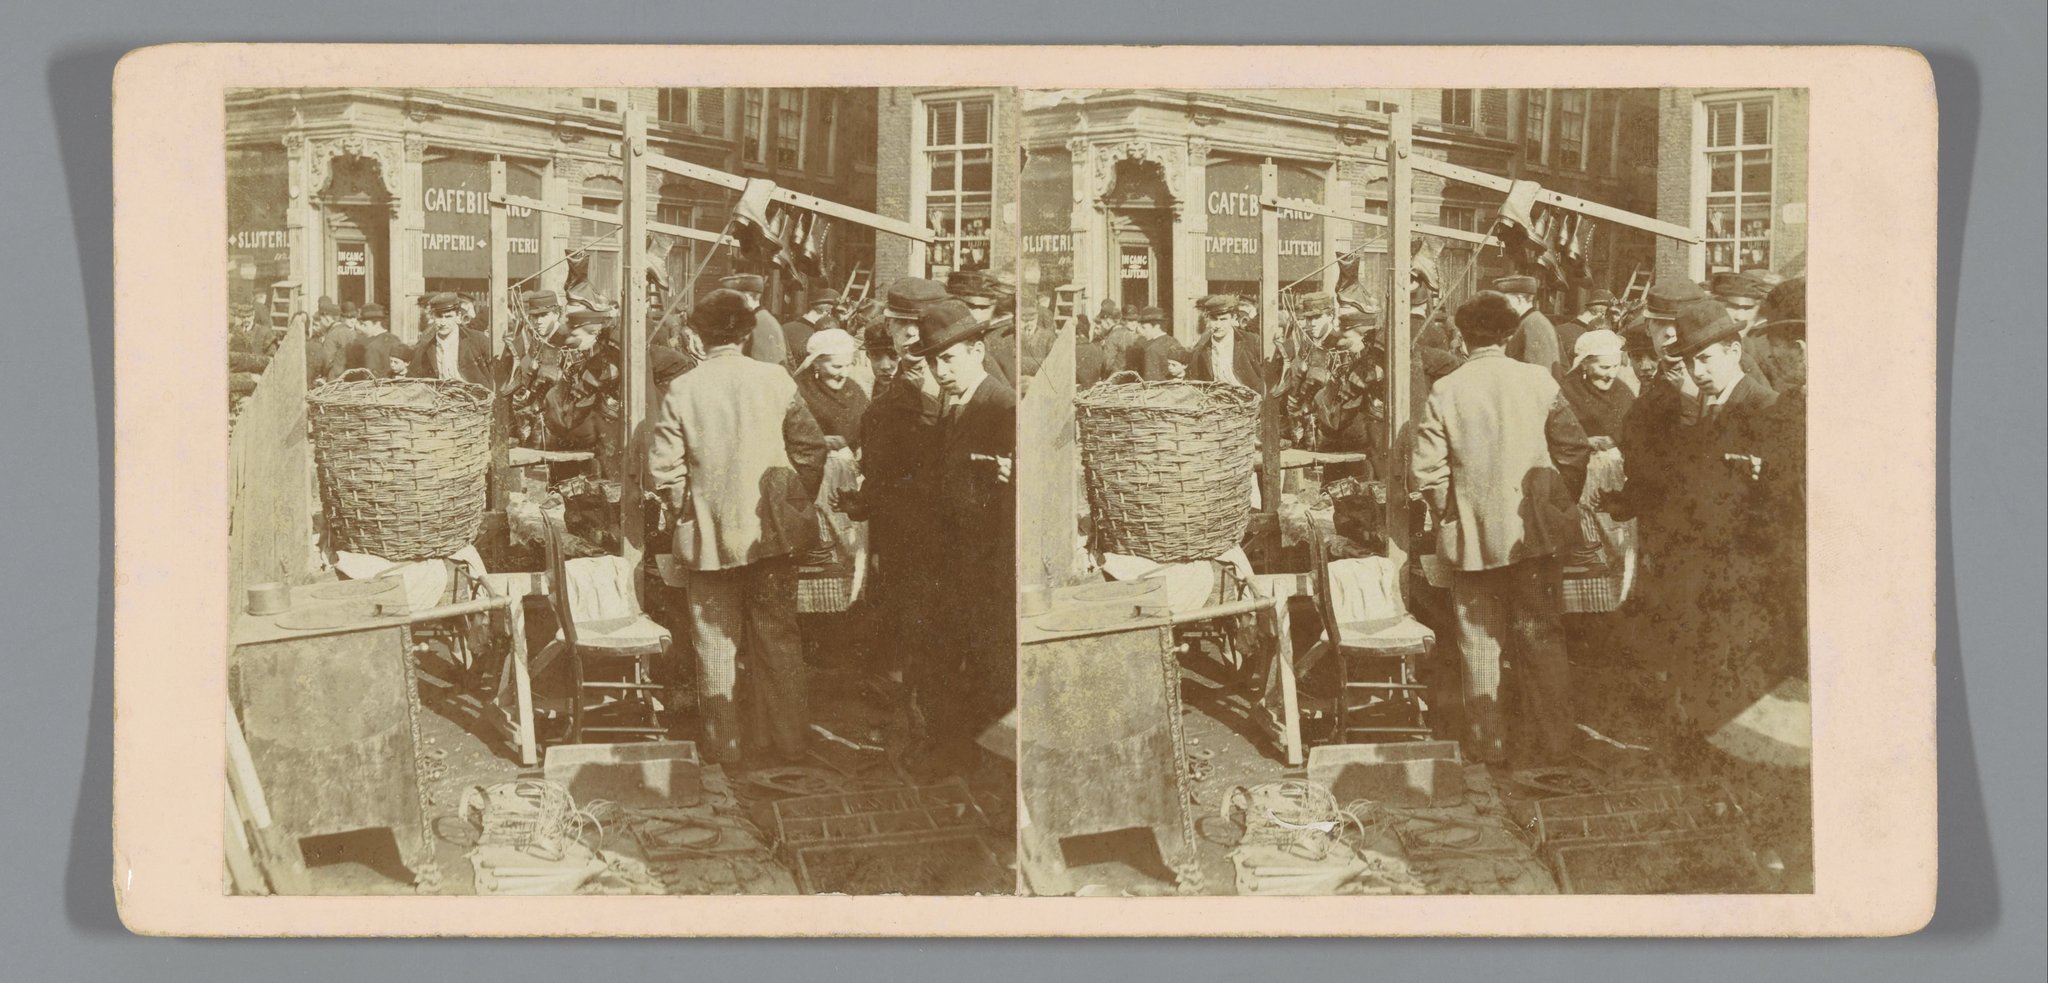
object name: stereograph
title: Markttafereel in Nederland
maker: Anonymous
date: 1890-1930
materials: paper, cardboard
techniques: gelatin silver print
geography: netherlands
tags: market, netherlands